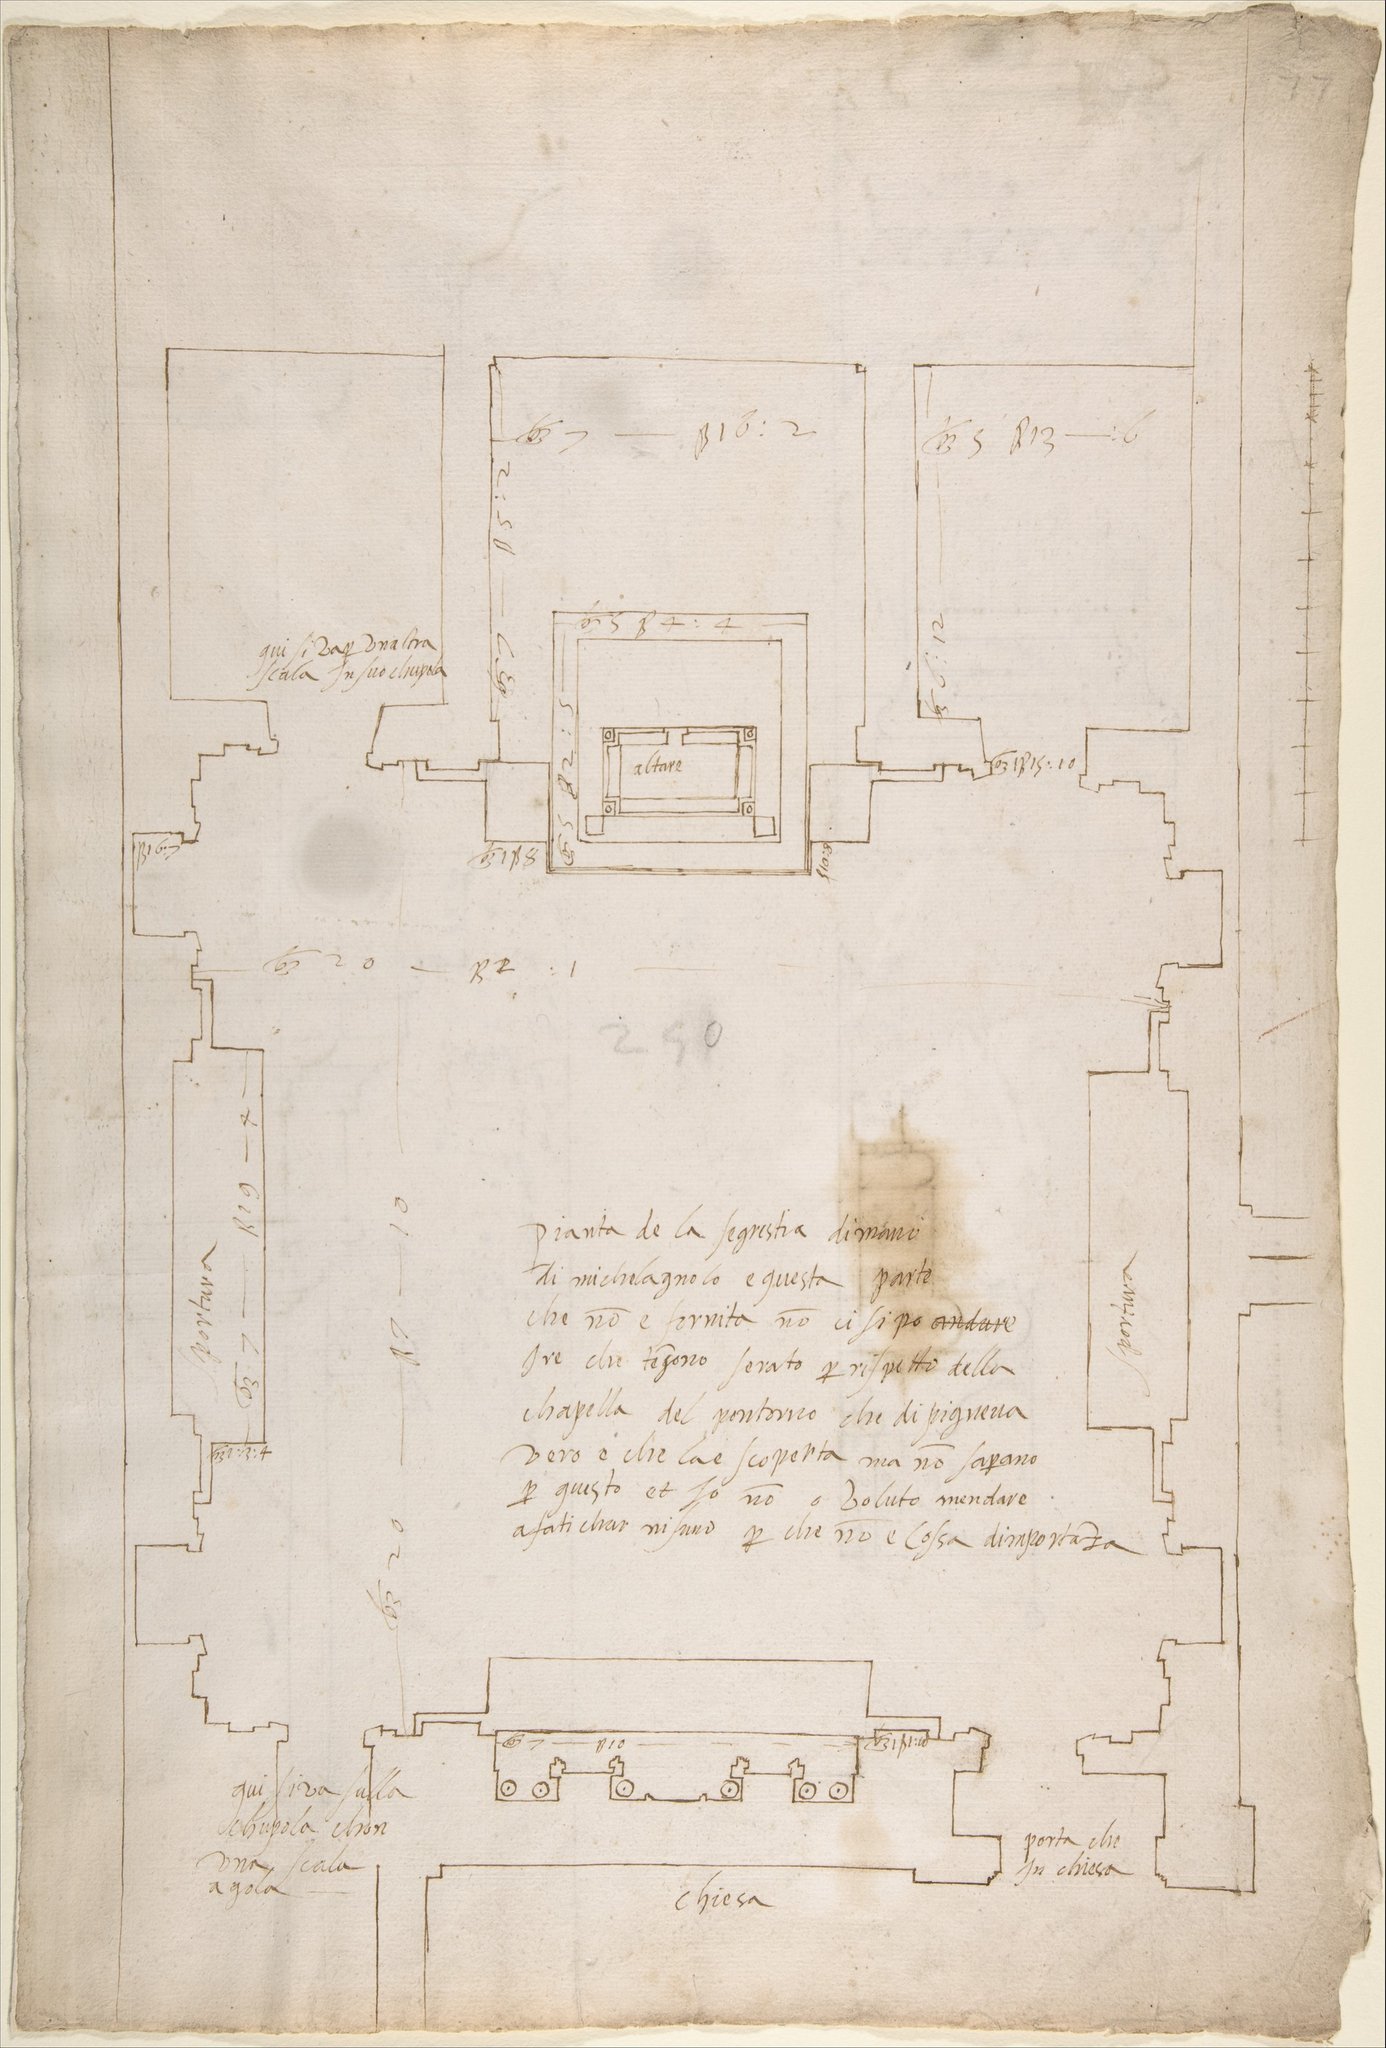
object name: drawing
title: San Lorenzo, New Sacristy, plan (recto) San Lorenzo, New Sacristy, details, elevation and section (verso)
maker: anonymous, french, 16th century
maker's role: draftsman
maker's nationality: french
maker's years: 1500-1600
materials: chalk, ink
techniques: incising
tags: architecture